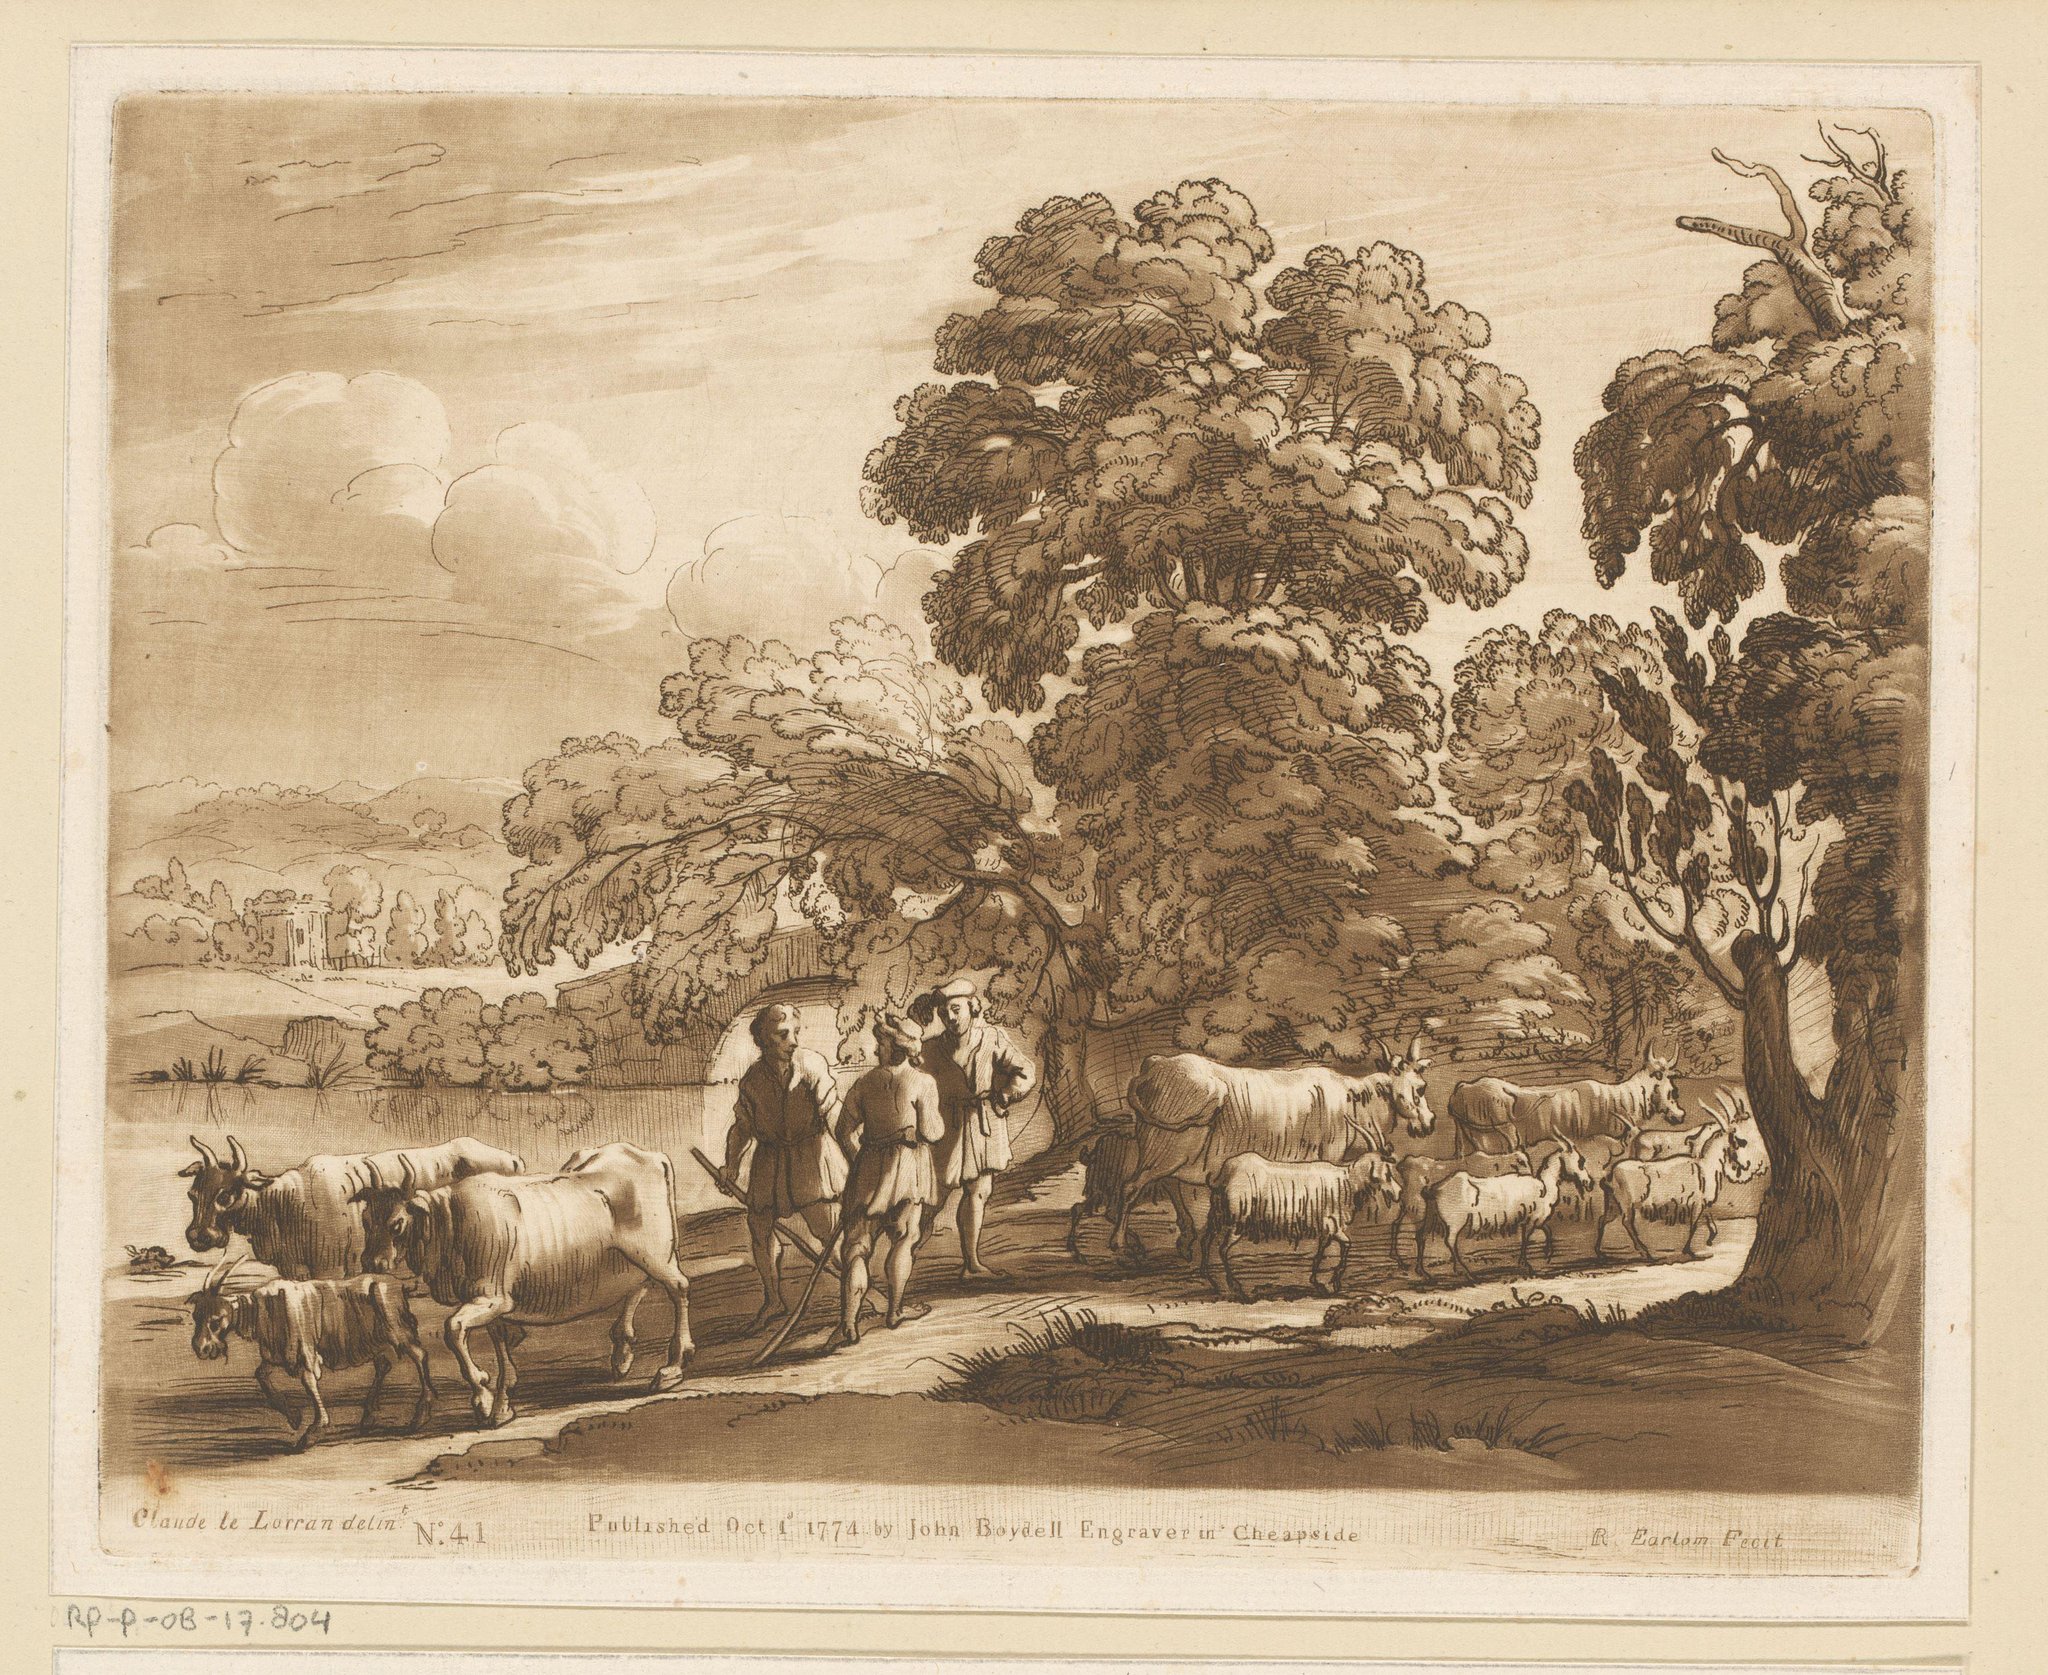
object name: print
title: Landschap met vee en drie pratende herders aan een rivieroever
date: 1774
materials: paper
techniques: etching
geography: london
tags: river, cattle, landscape with bridge, viaduct or aqueduct, cattle driving, cattle driver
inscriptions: date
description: Vanaf 1774 publiceerde John Boydell tweehonderd prenten naar het tekeningenboek Liber Veritatis van Claude Lorrain, in het bezit van de hertogen van Cavendish. Deze prenten werden vanaf 1777 in twee volumes gebundeld uitgegeven.